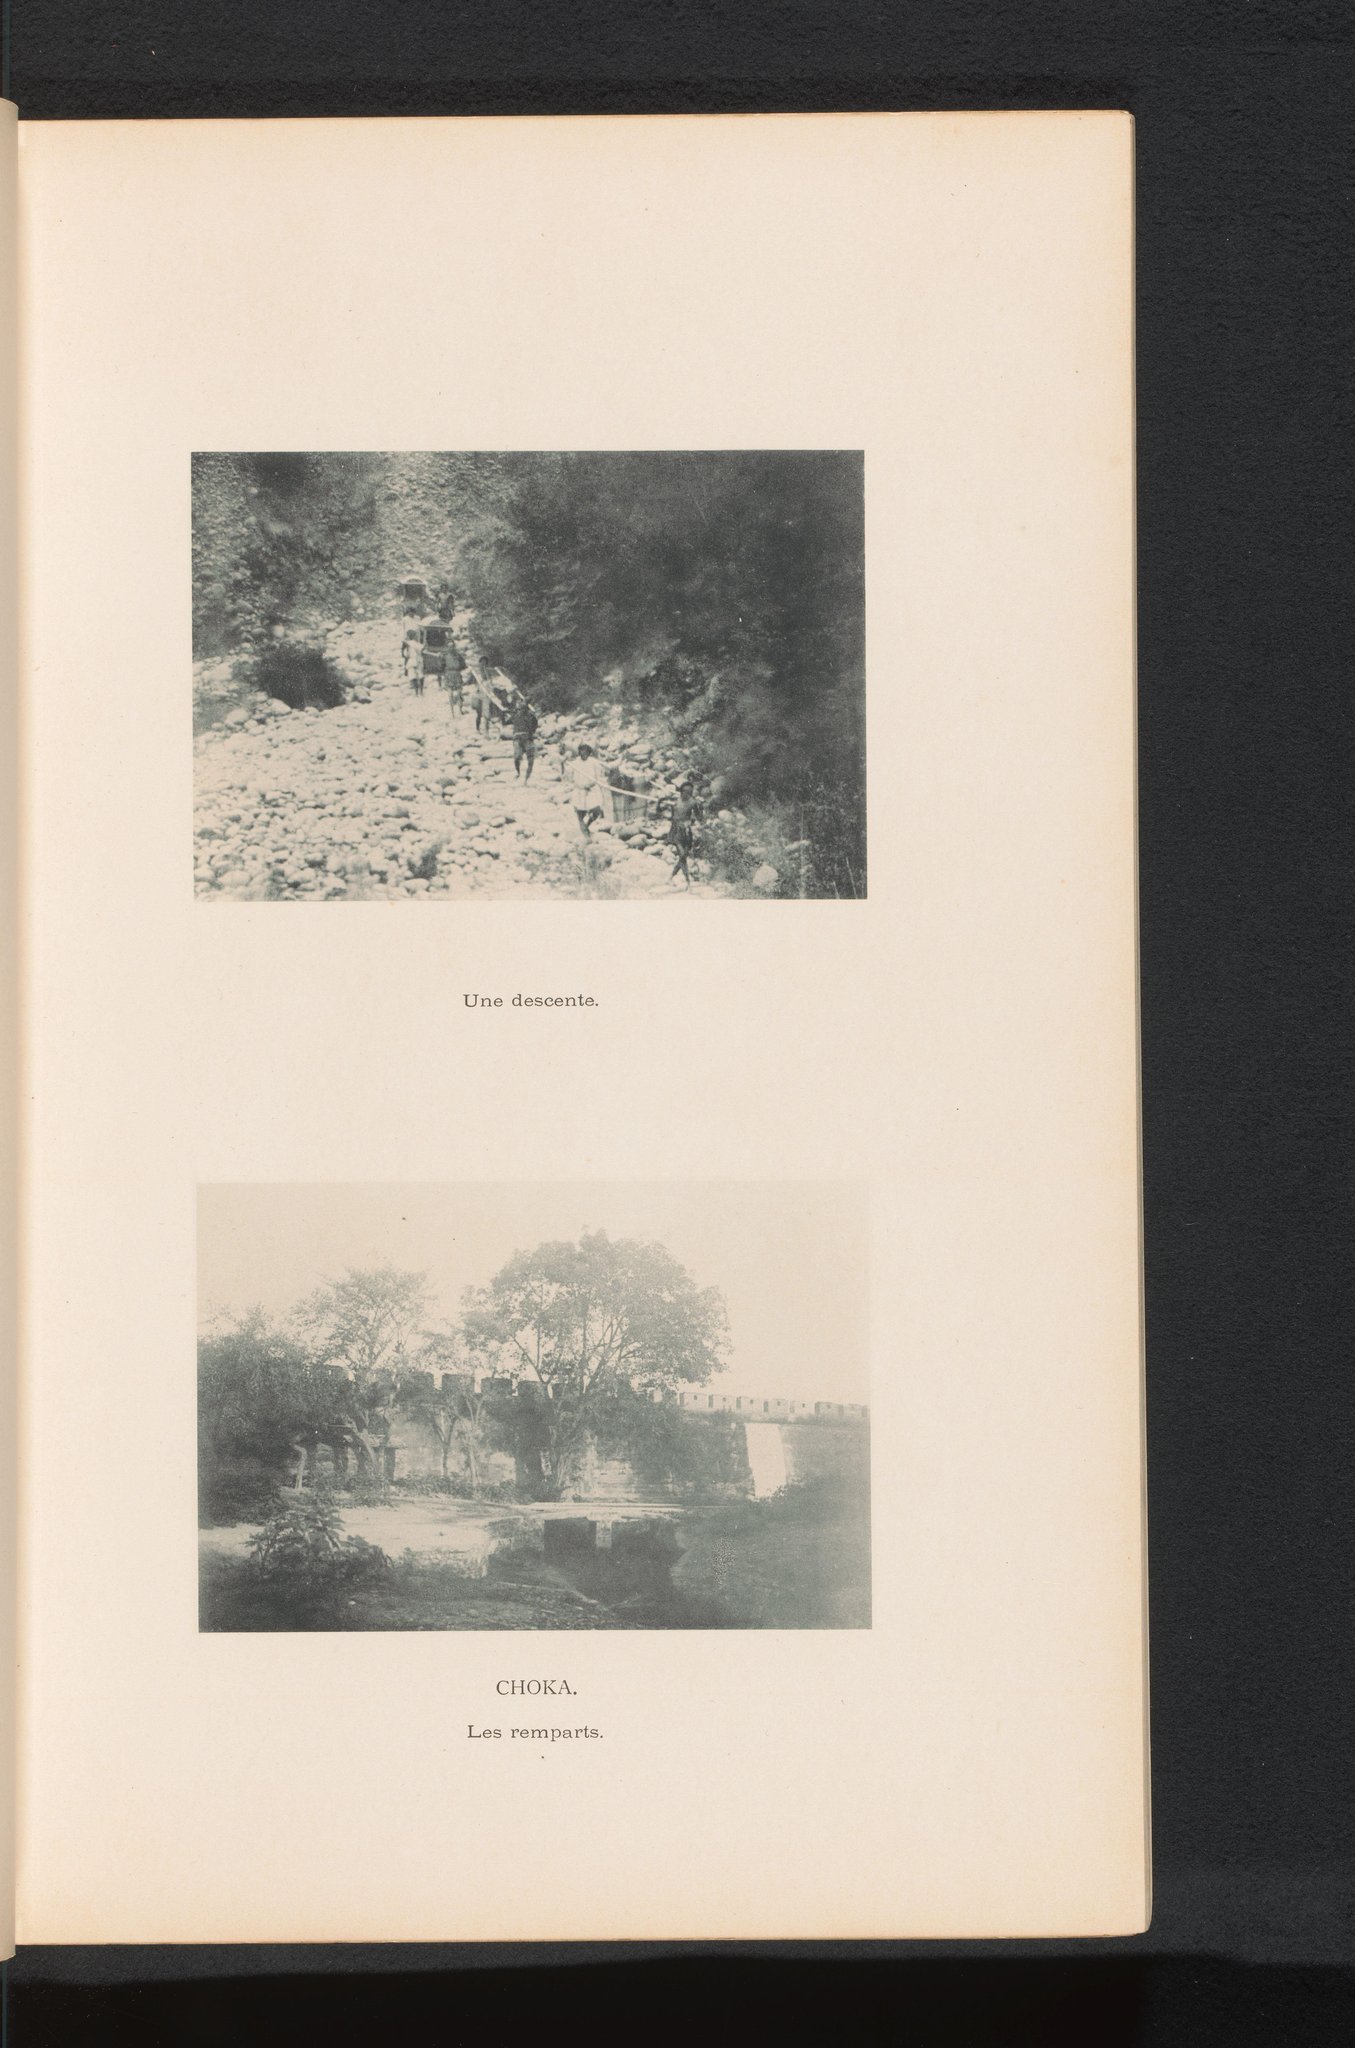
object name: page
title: Une descente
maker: Anonymous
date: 1891-1896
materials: paper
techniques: photograph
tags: mountain climbing, mountaineering, city-walls